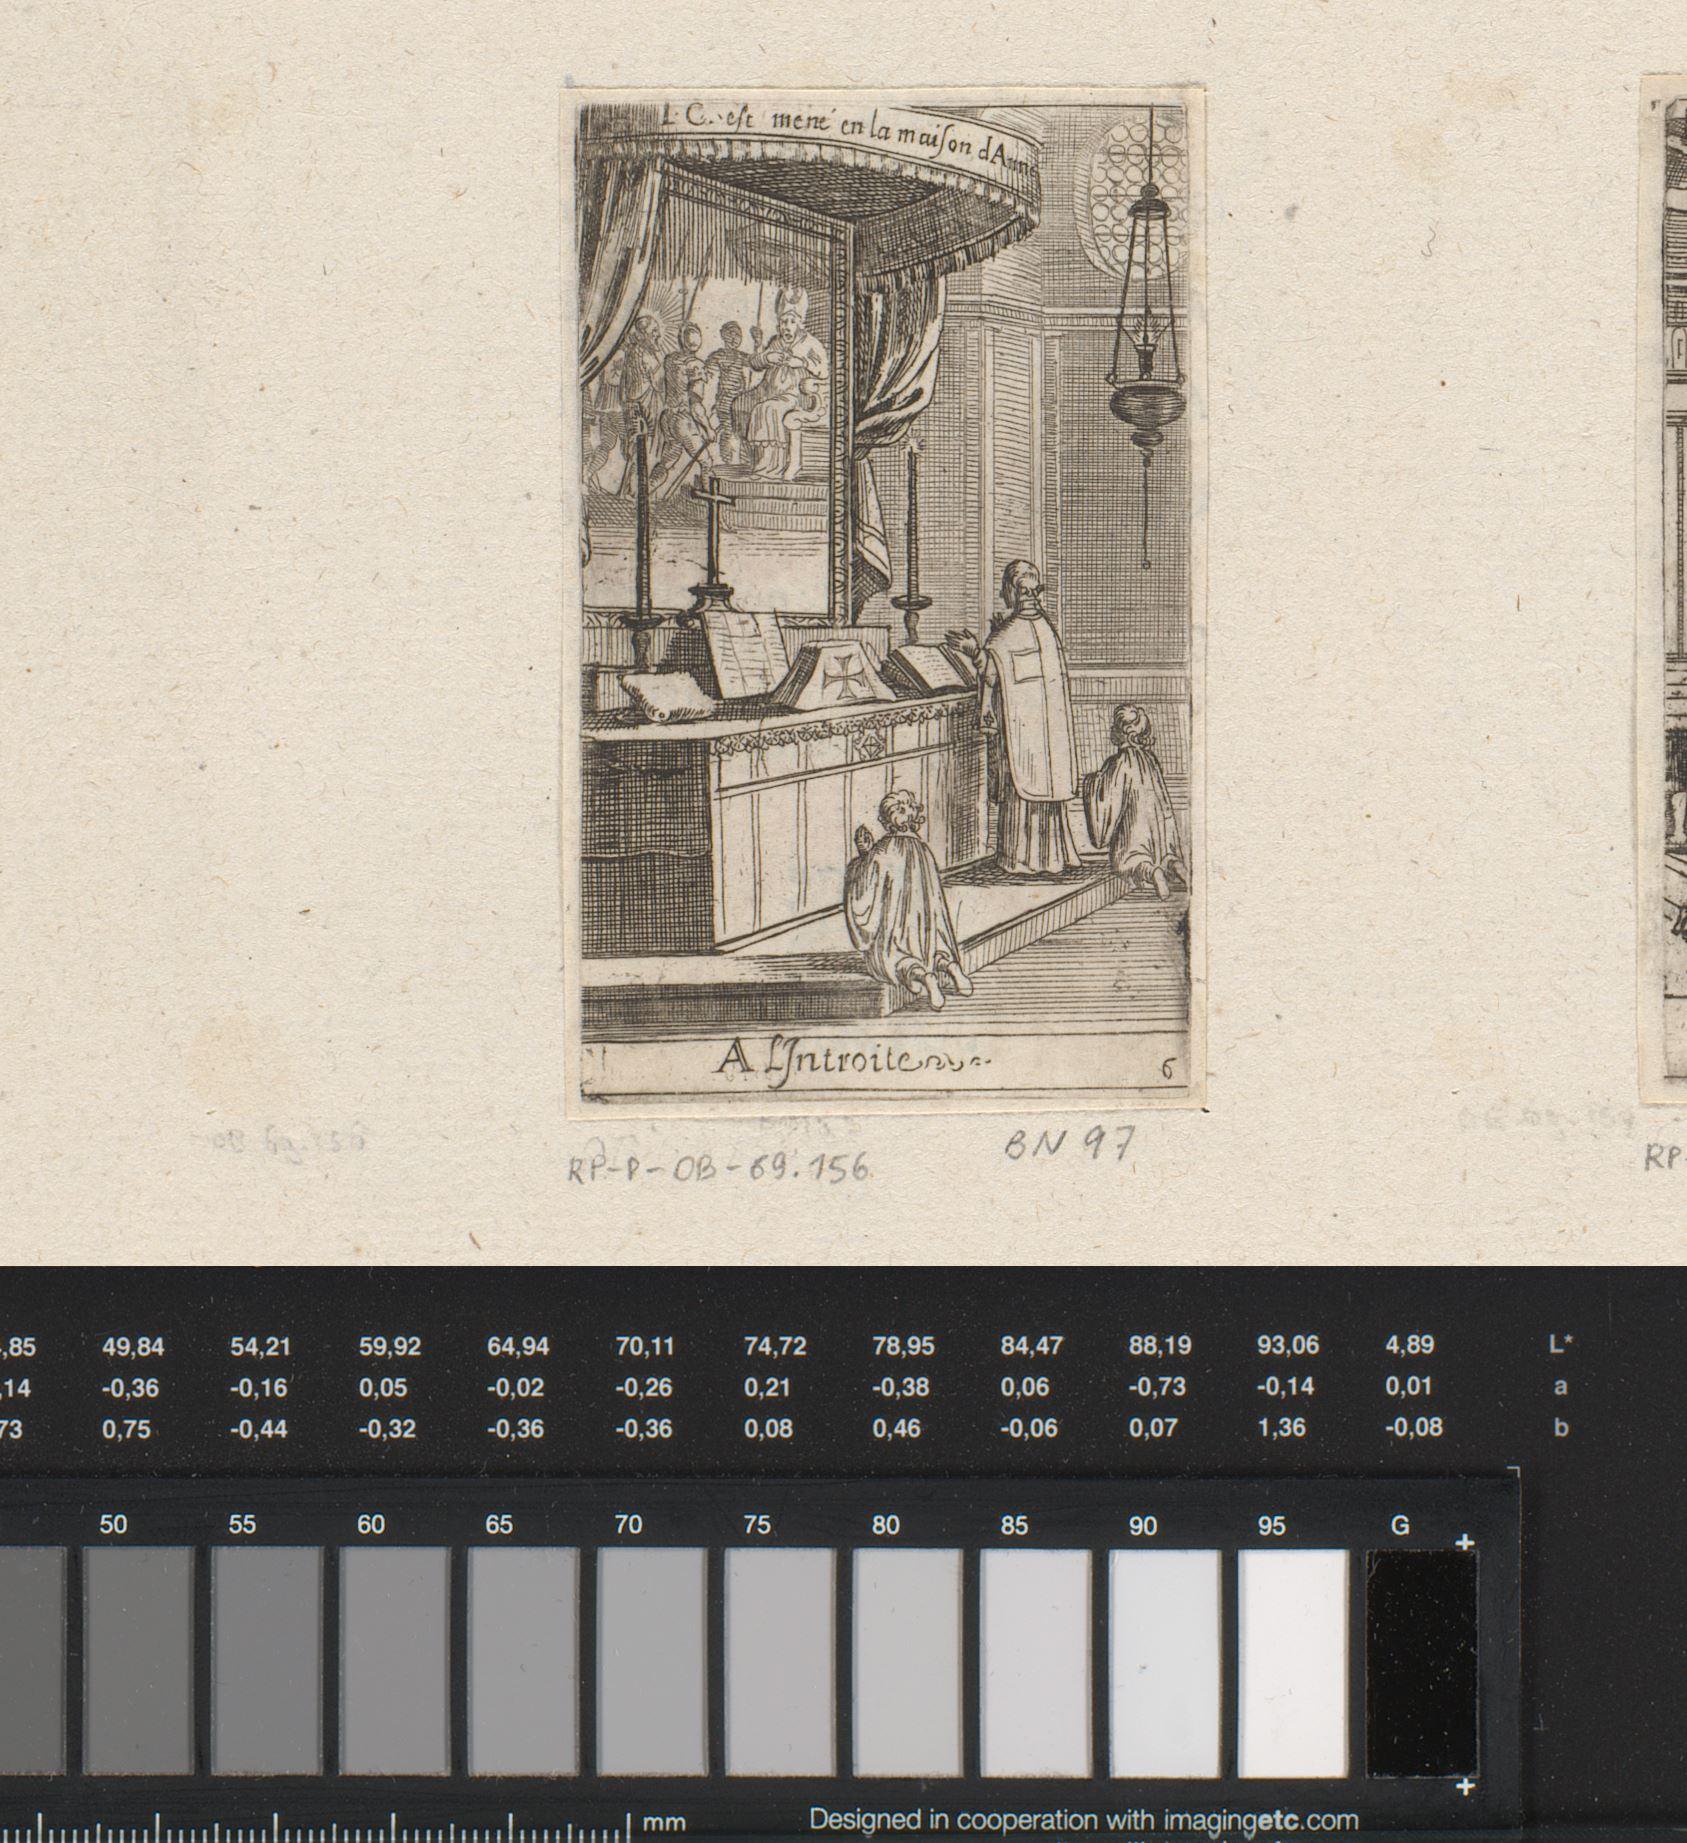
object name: book illustration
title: A L'Introite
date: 1661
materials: paper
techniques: etching, letterpress printing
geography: france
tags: priest (roman catholic), altar with altar-piece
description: Prent uit: Mengin, L. Tableaux ou sont representees la passion de N.S. Christ et les actions du prestre a la S. Messe (...). Metz: Claude Bouchard, 1661.